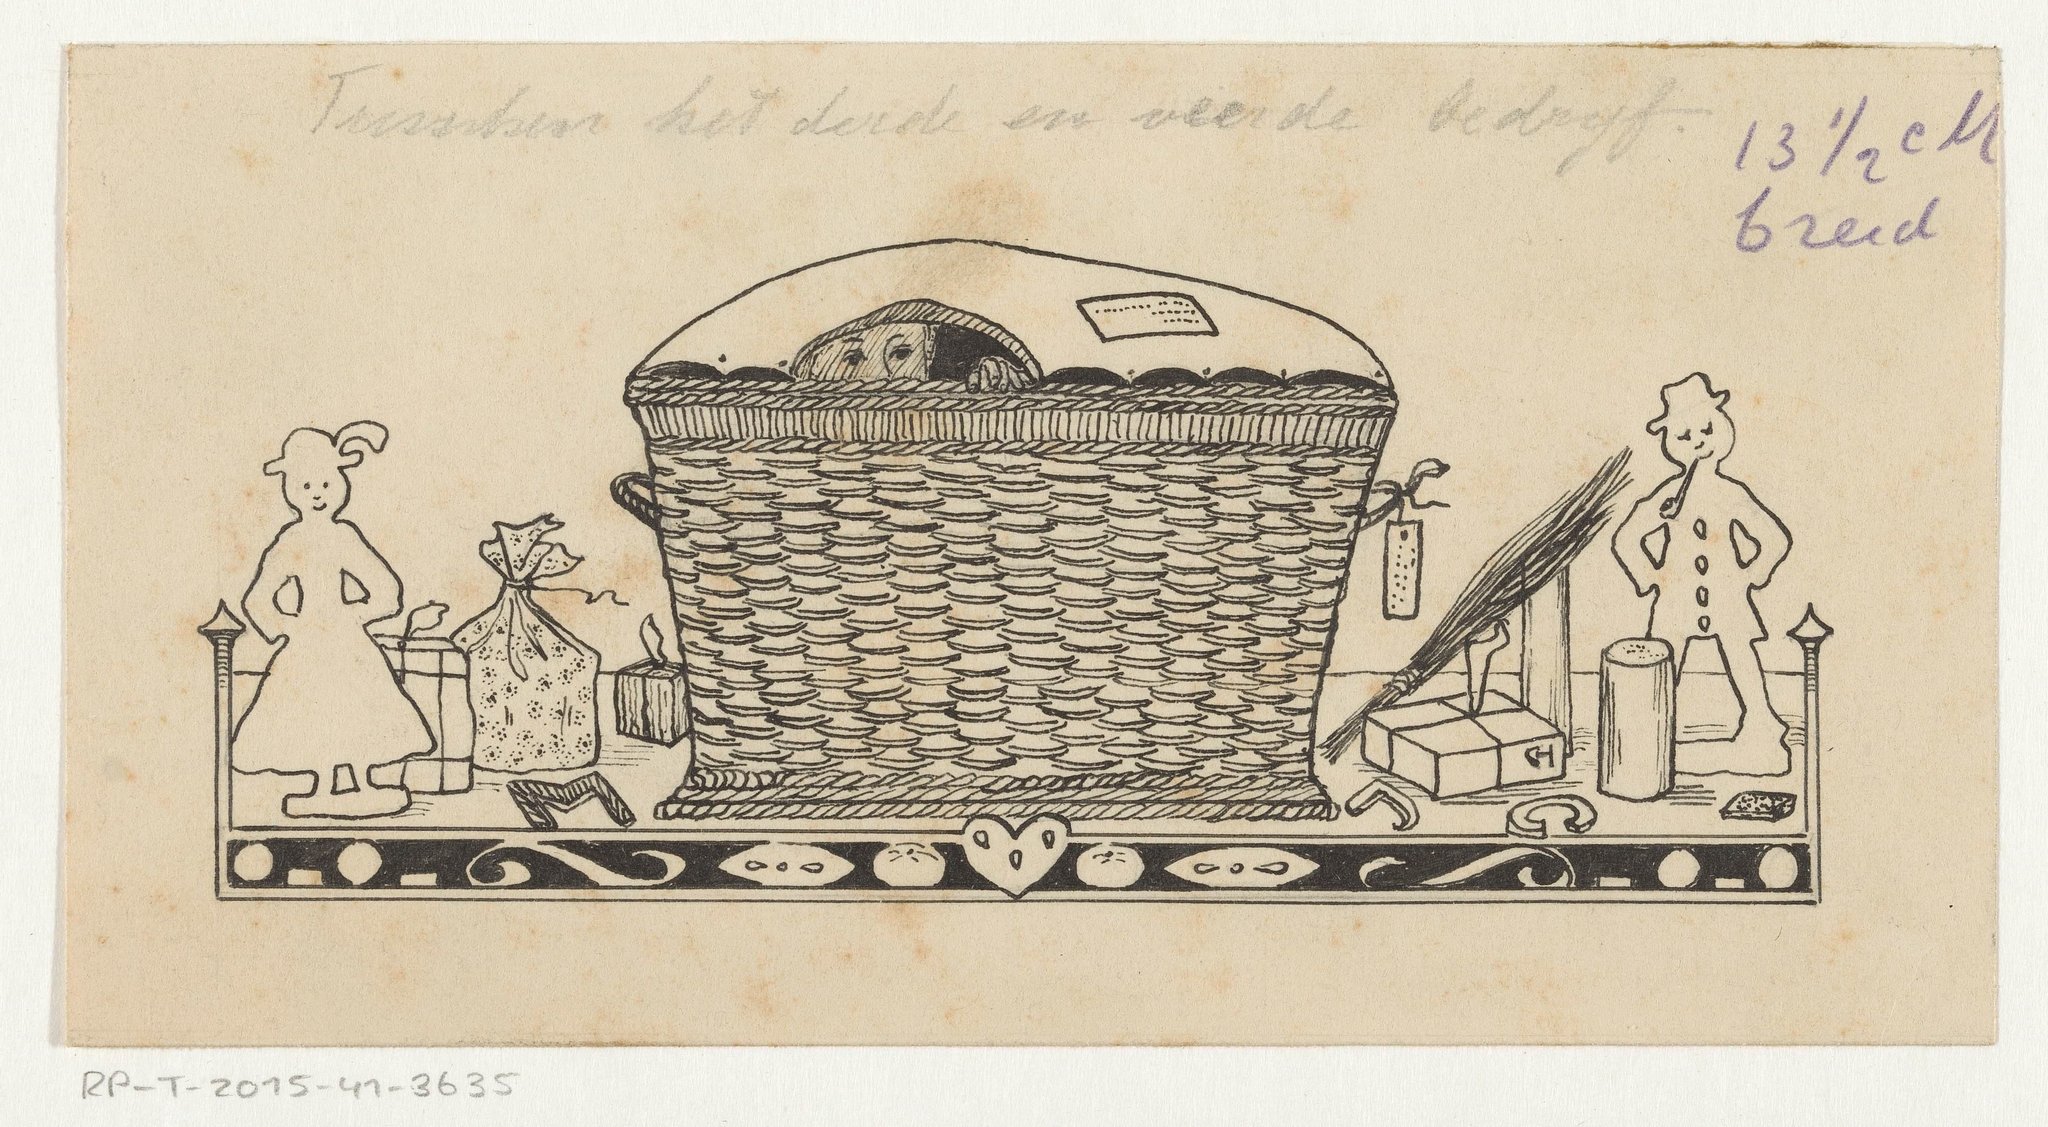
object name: boekillustratie ontwerp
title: Mand met Sinterklaascadeaus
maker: Anonymous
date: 1890-1940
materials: ink, paper, pencil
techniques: pen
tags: container made of plant material other than wood: basket, festivities on st. nicholas (eve) (december 5)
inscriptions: :, annotation: ‘Tusschen het derde en vierde bedrijf’, signature: ‘CH’, collector's mark: Lugt 2228a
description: Op een tafel staat een rieten mand die is afgedekt met een doek. In de mand zit een kind, dat tussen de doek en de rand van de mand naar buiten spiekt. Rond de mand liggen Sinterklaascadeaus, snoepgoed en een roe.